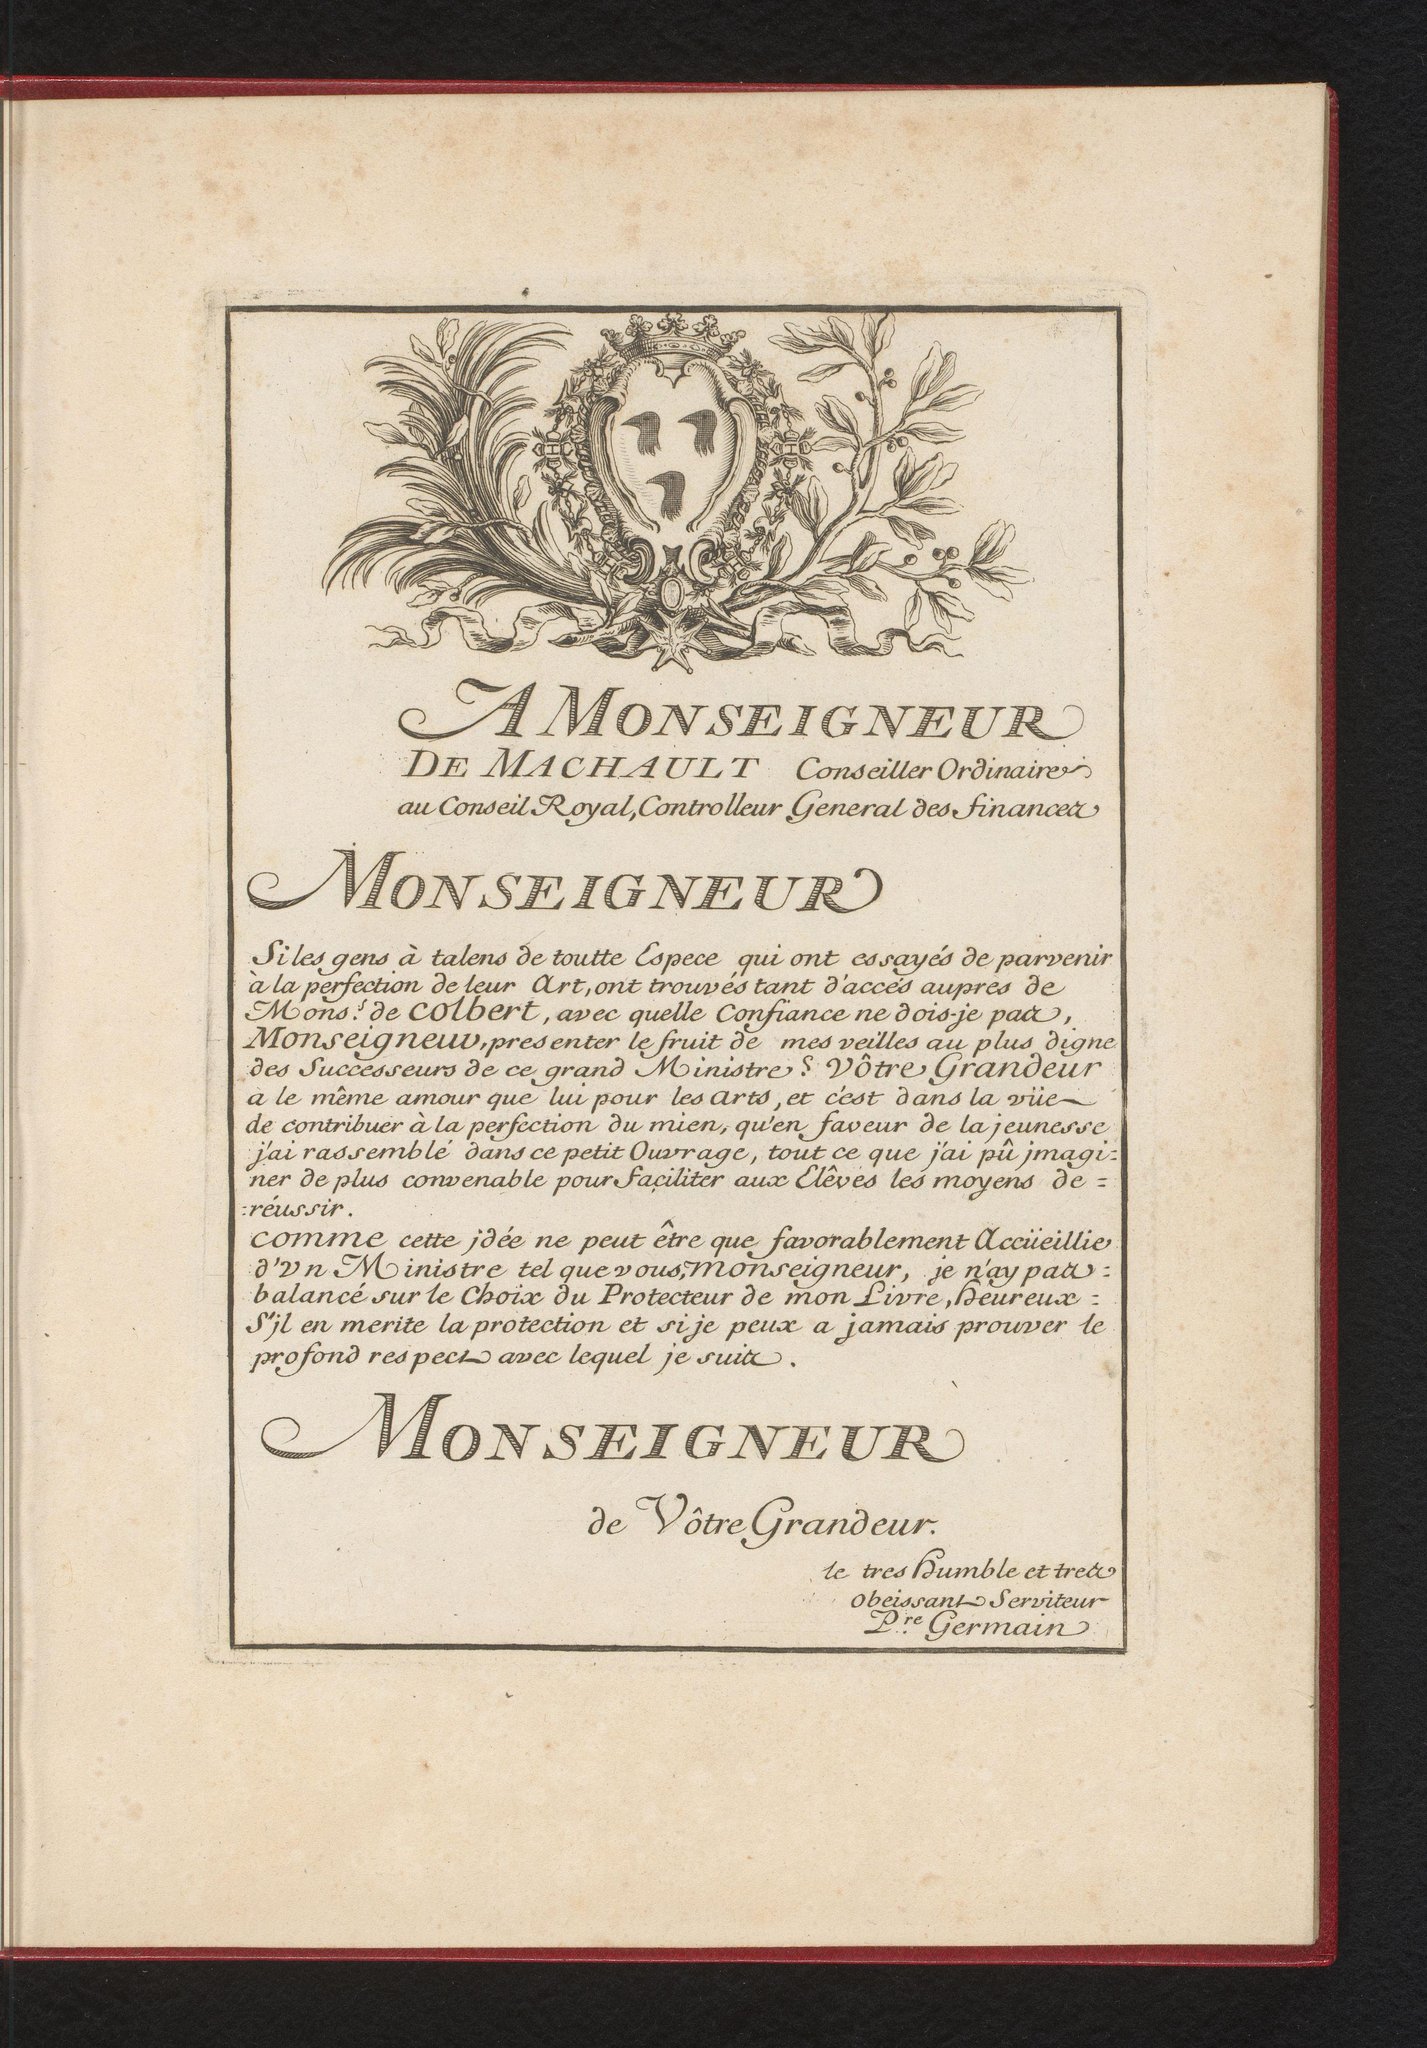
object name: album leaf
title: Opdracht bij een serie ontwerpen voor voorwerpen uit de edelsmeedkunst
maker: jacques jean pasquier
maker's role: print maker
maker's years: 1718-1785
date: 1748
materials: paper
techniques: etching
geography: paris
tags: politician, jean-baptiste de machault d'arnouville, armorial bearing, heraldry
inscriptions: date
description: Een aantal van de objecten in deze reeks heeft een eigen ondertitel, die verwijst naar genummerde 'cahiers' (afleveringen) waarin de prenten werden uitgegeven. Het is onduidelijk welke objecten recies bij welke aflevering horen. Daarom is die ondertitel enkel verwerkt bij de prent waarop die voorkomt.